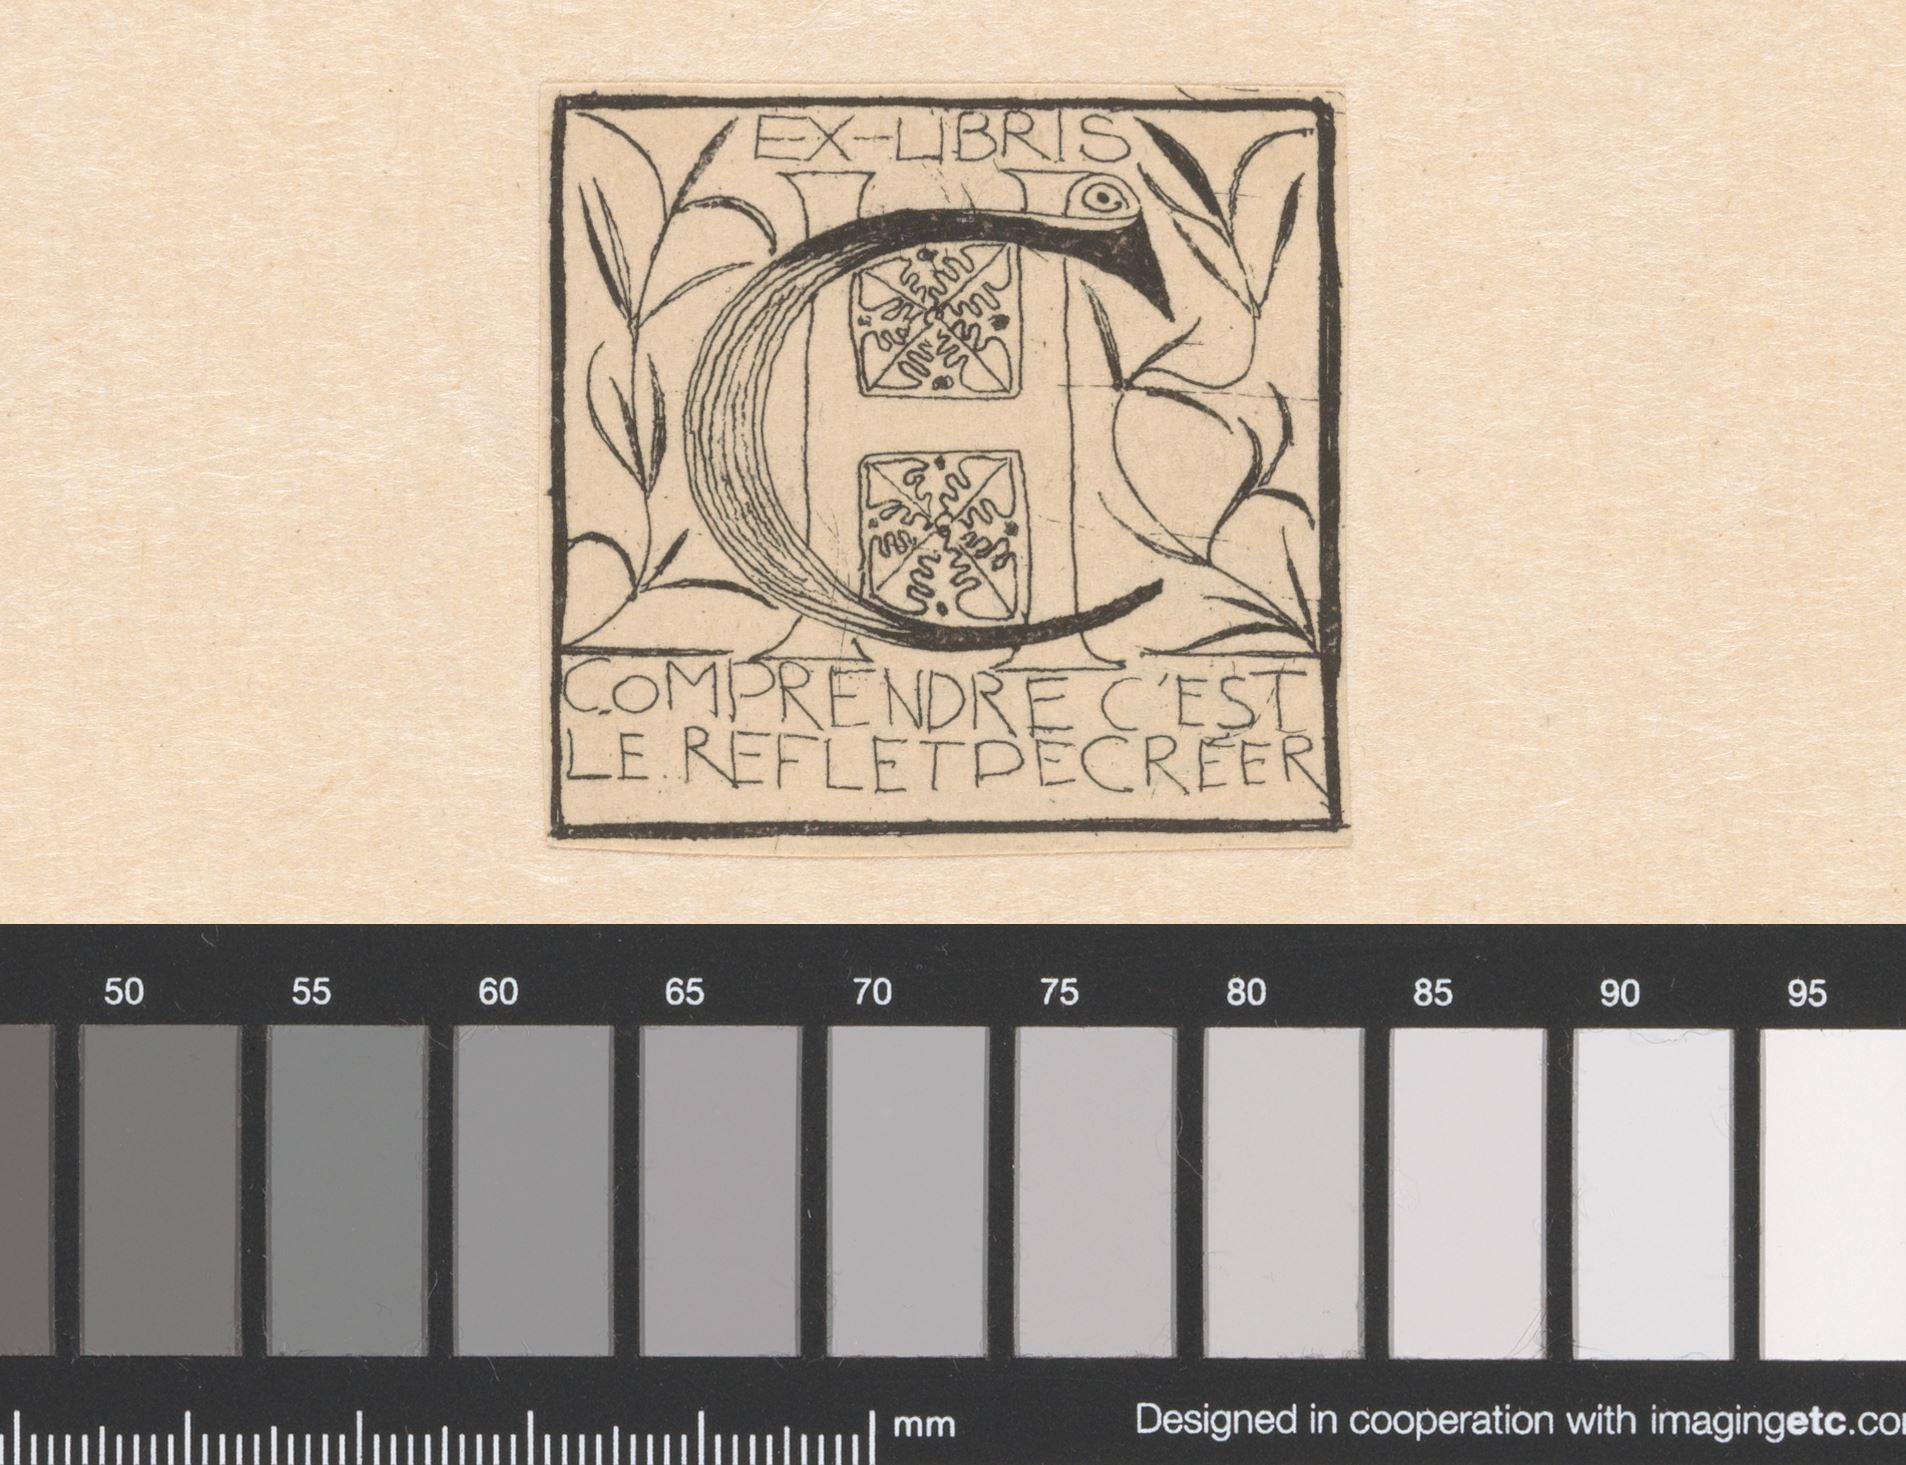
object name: print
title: Ex libris voor Dora Calisch-Hijmans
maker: gerrit willem dijsselhof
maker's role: designer, draughtsman, print maker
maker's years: 1866-1924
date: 1886-1899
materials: paper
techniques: woodcut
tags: arnhem, amsterdam, letter combinations such as letterword, anagram, letter square, monogram, etc.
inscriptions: collector's mark: Lugt 2228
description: Onder de letters 'C' en 'H' de tekst 'Comprendre, c'est le reflet de créer' van de Franse schrijver Auguste Villiers de L'Isle-Adam.